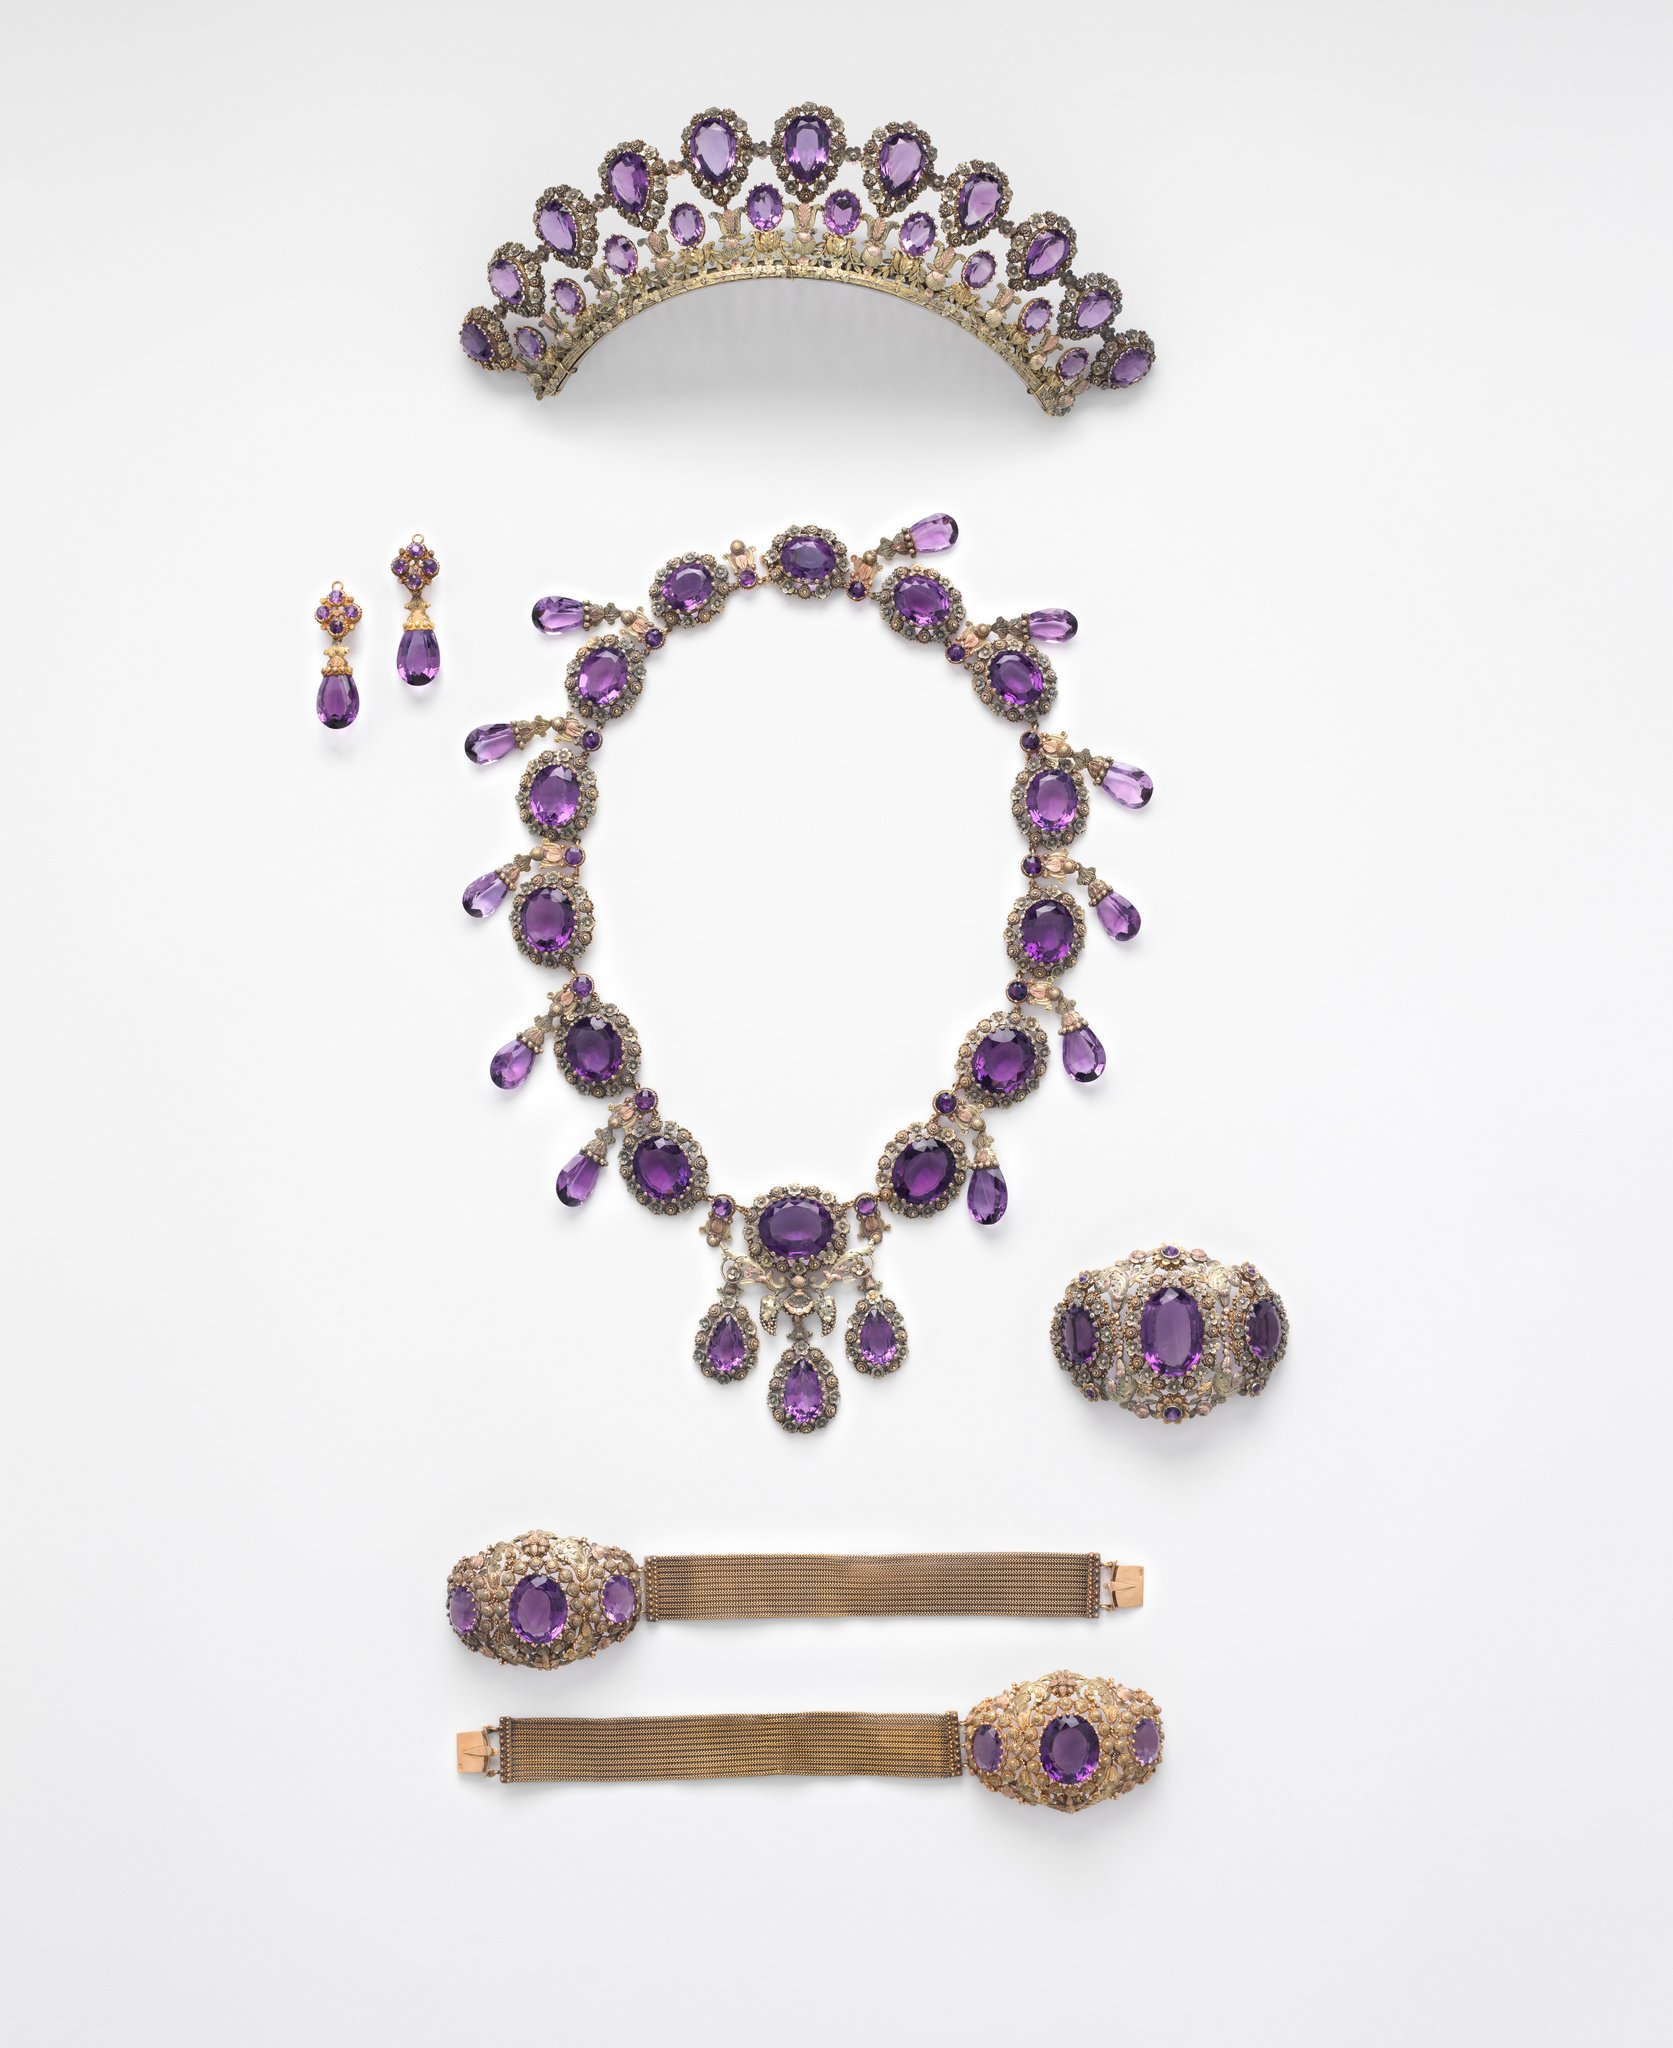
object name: comb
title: Comb (part of a set)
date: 1830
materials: amethyst, gold